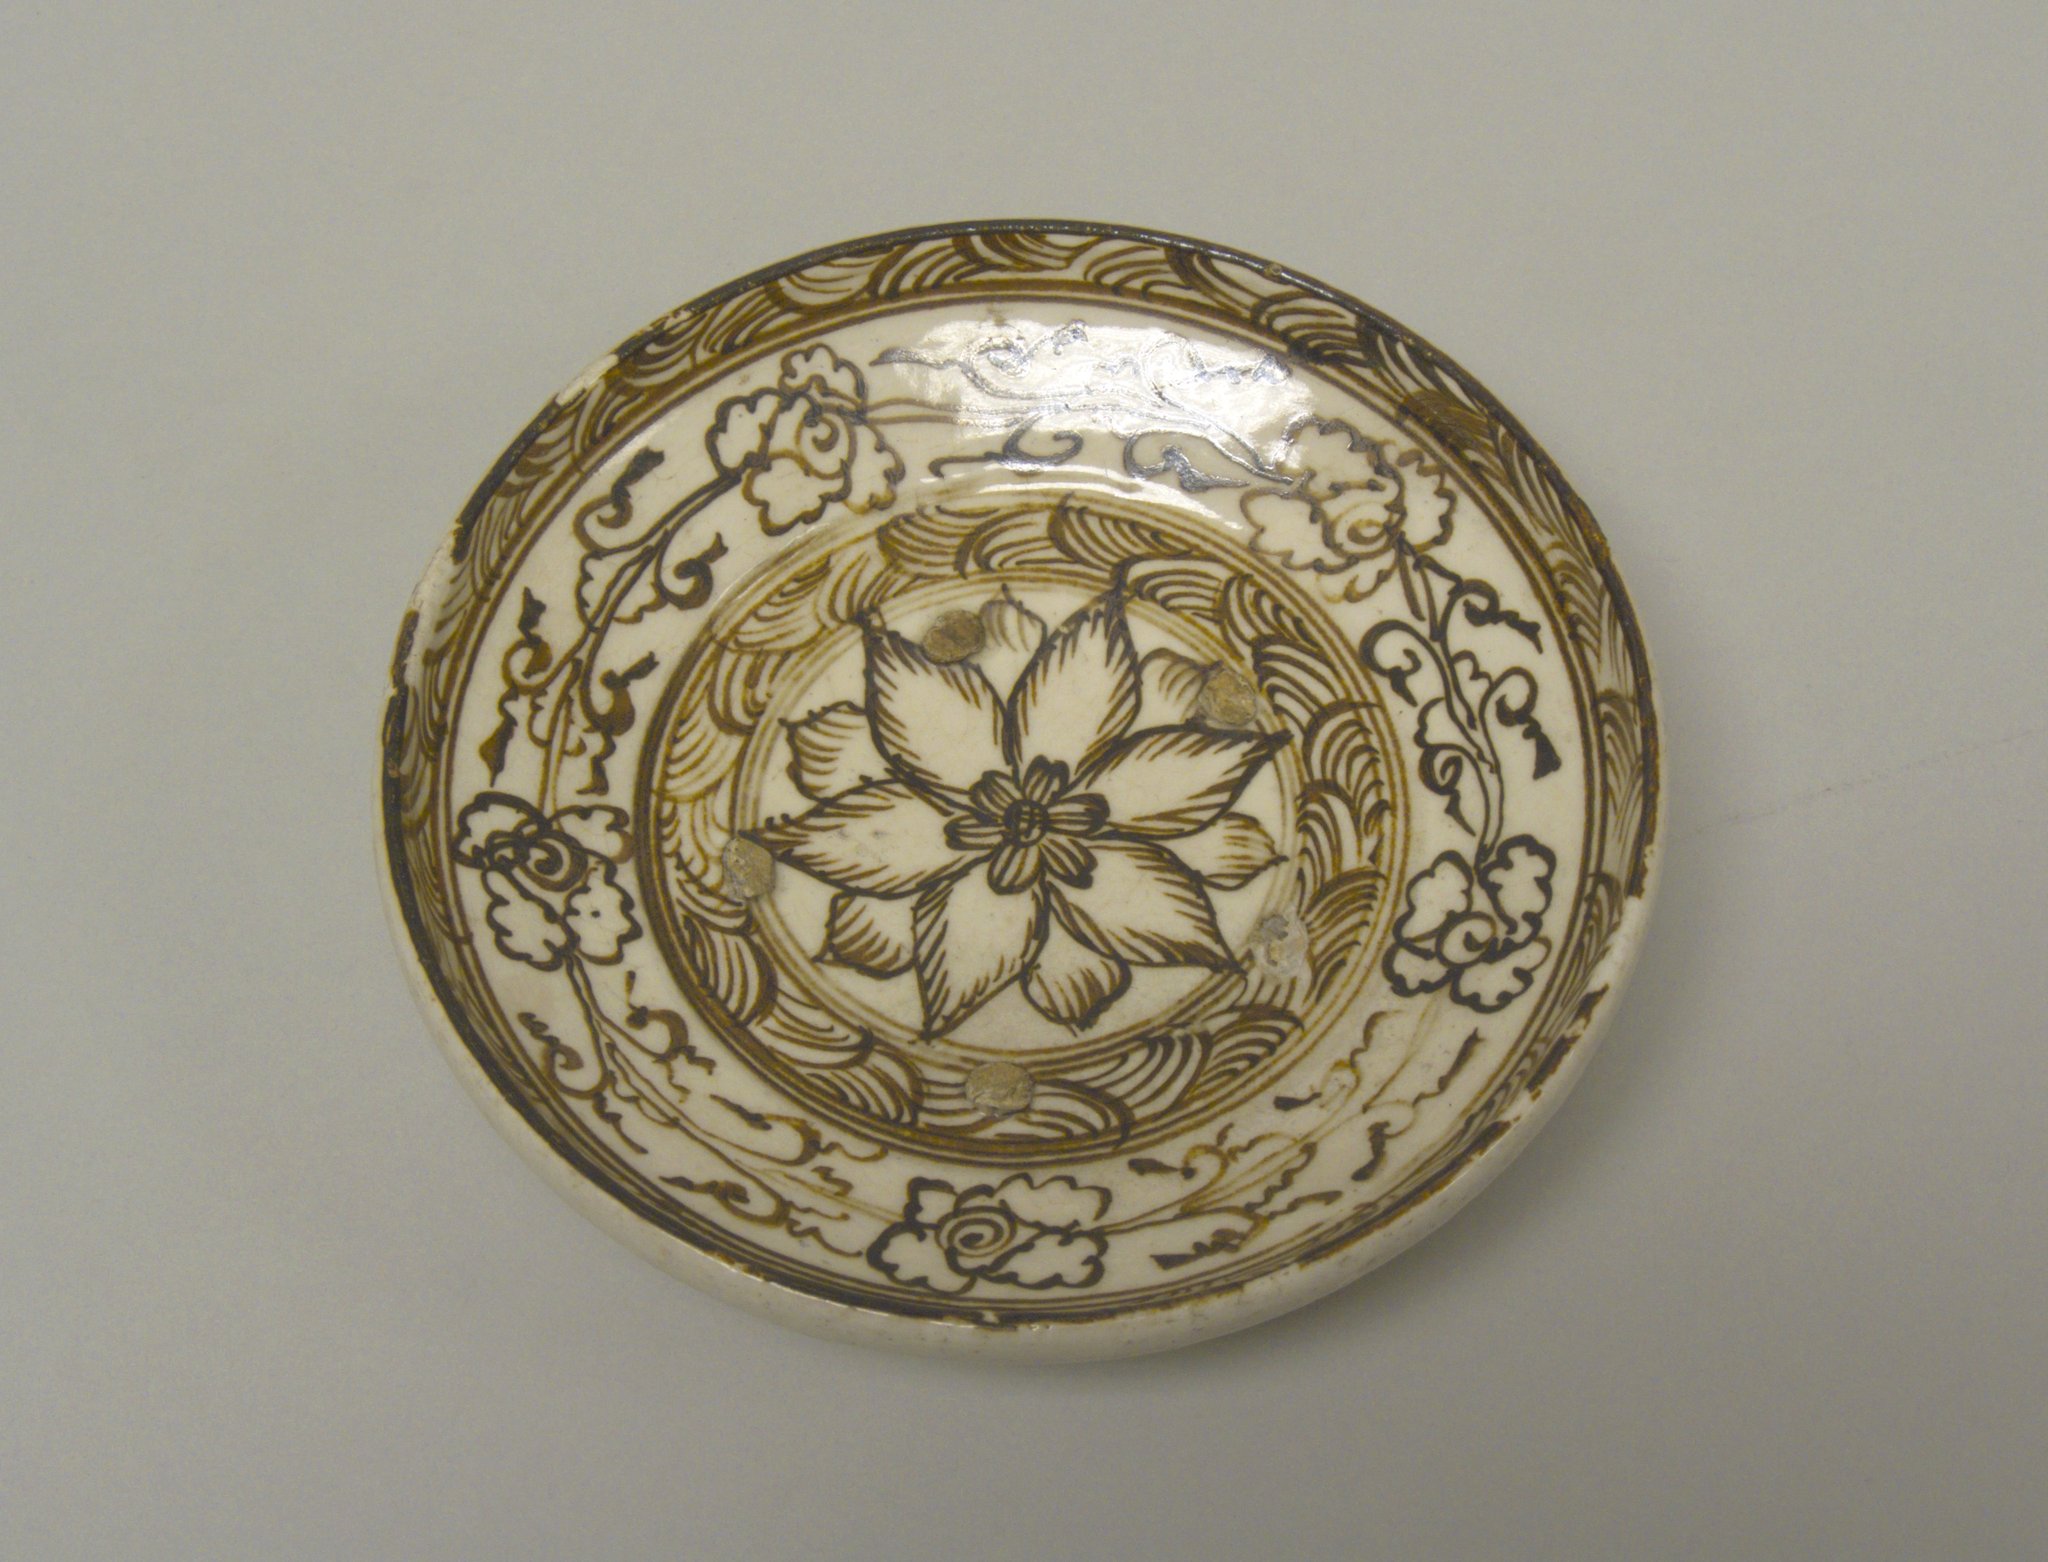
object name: dish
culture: chinese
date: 1271-1368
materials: stoneware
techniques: painting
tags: flowers